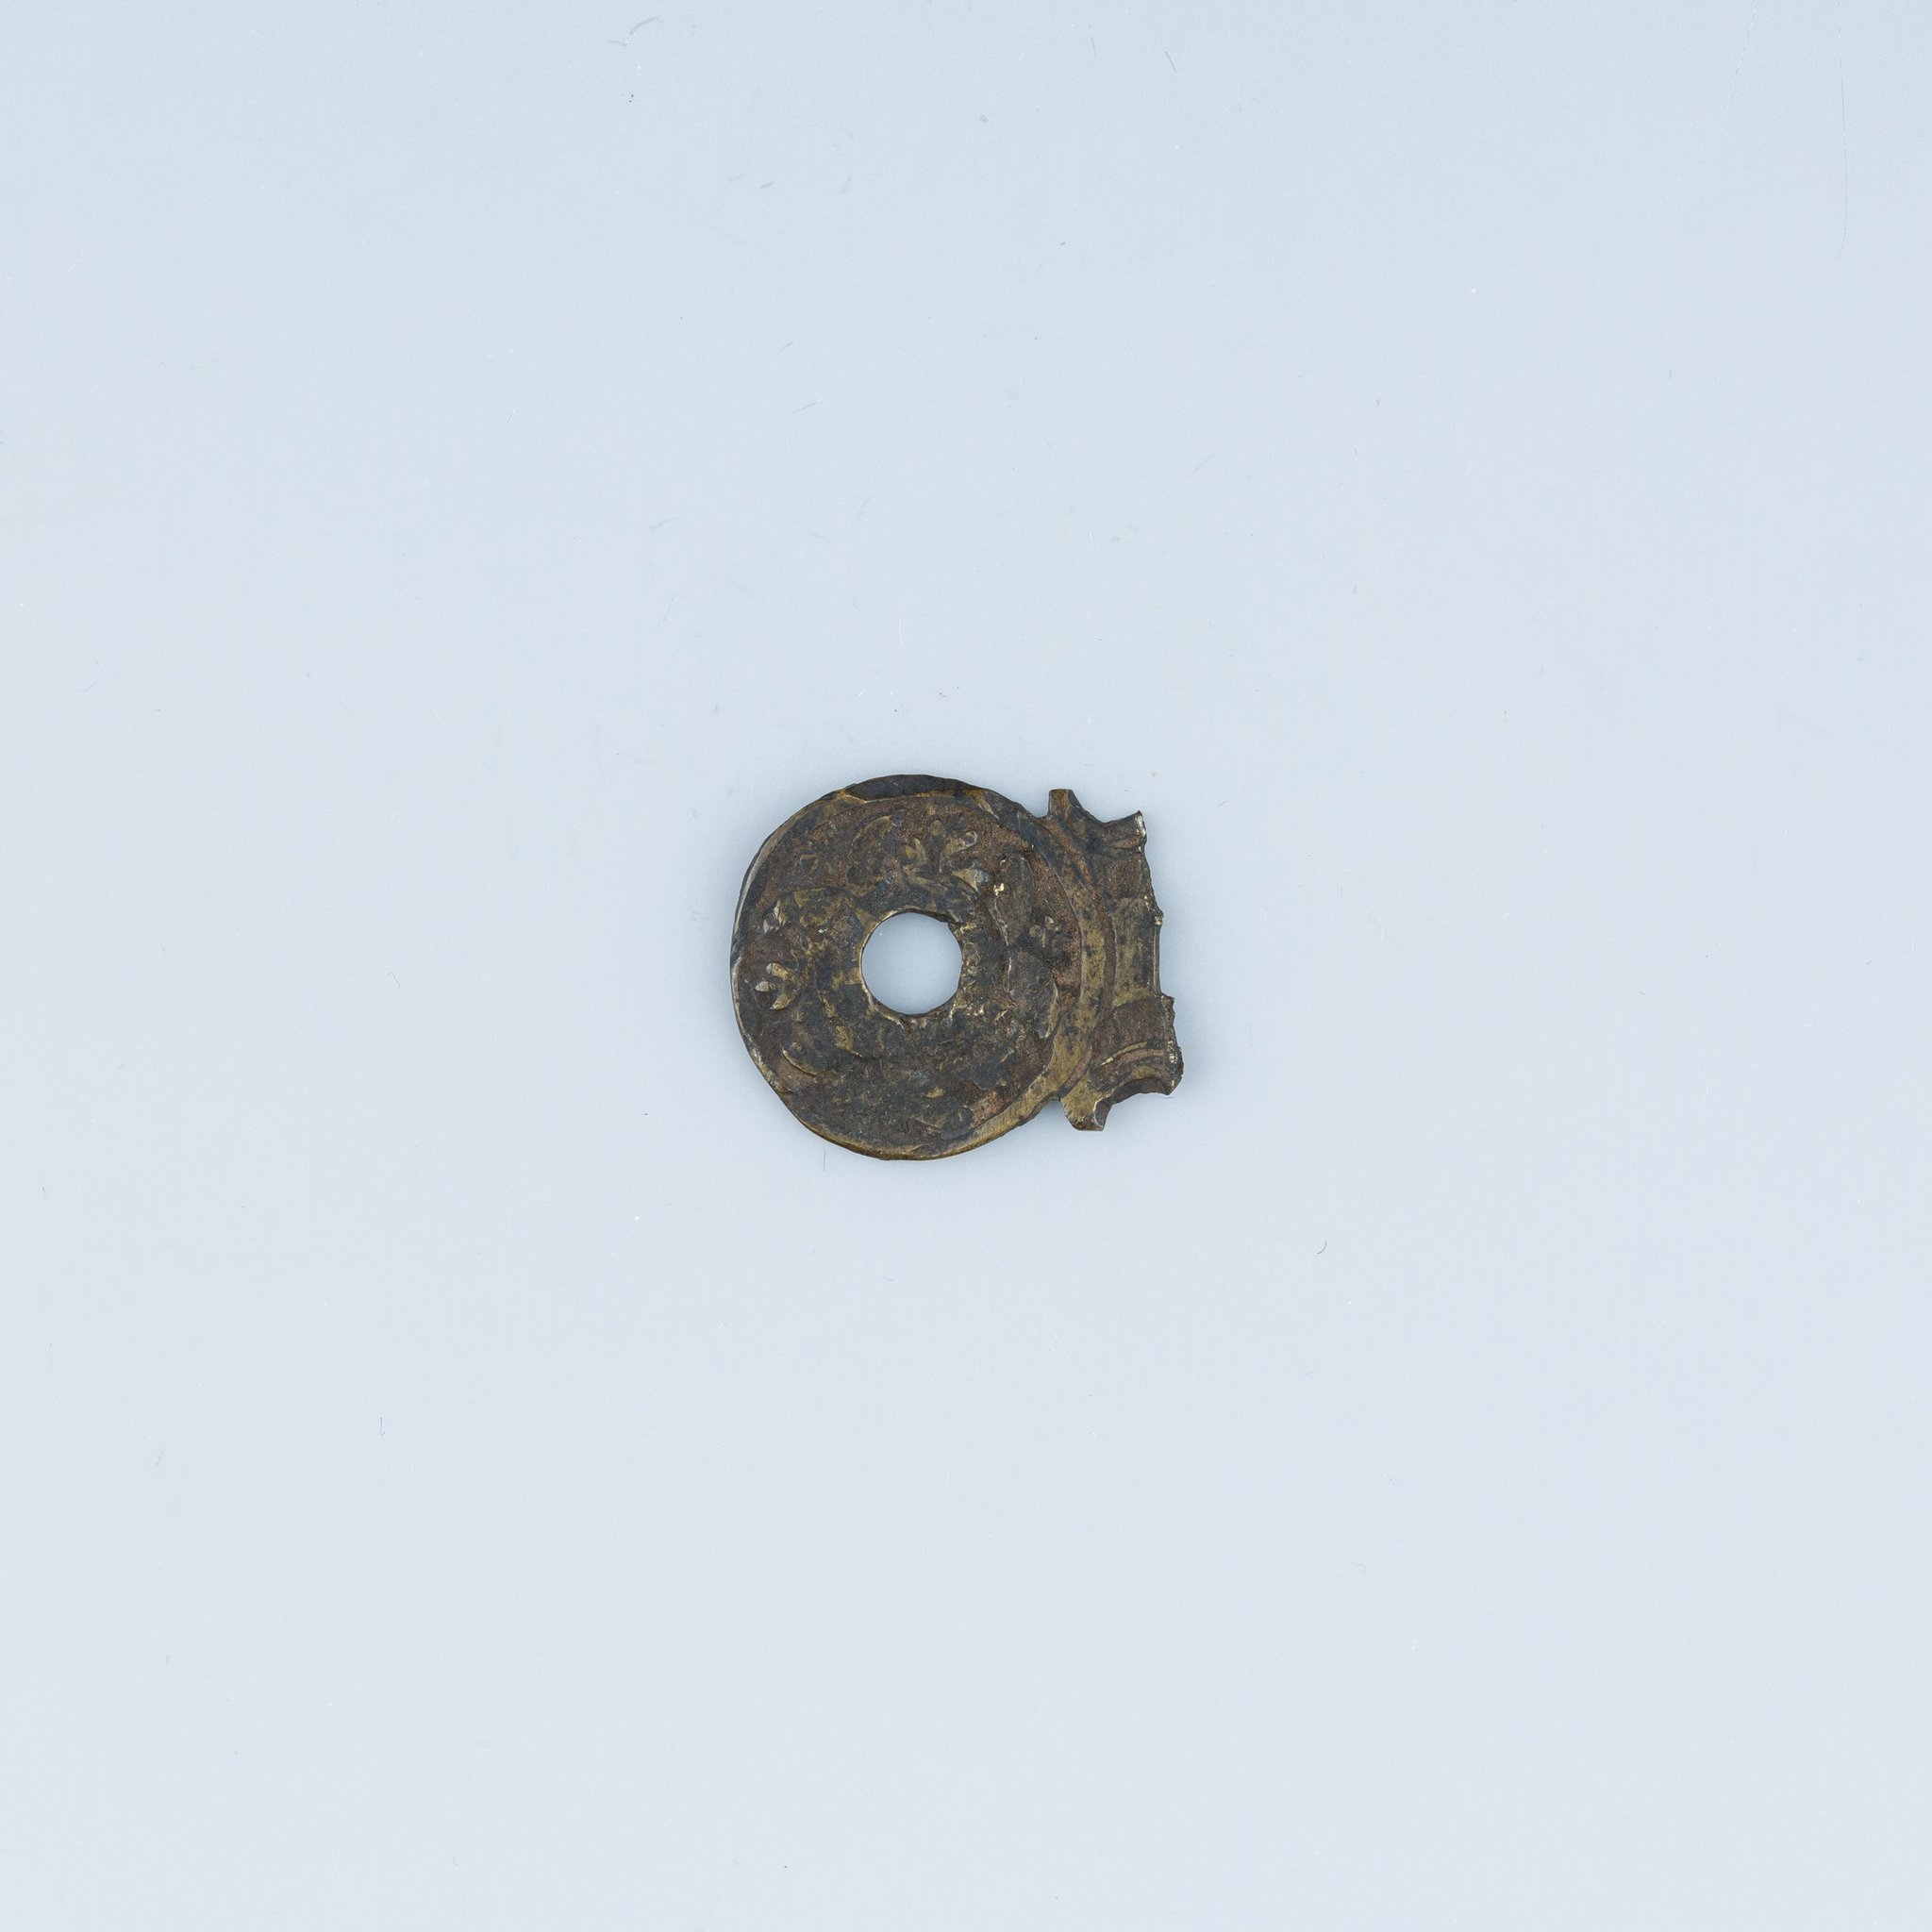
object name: buckle fragment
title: Fragment of Buckle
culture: german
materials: brass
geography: germany